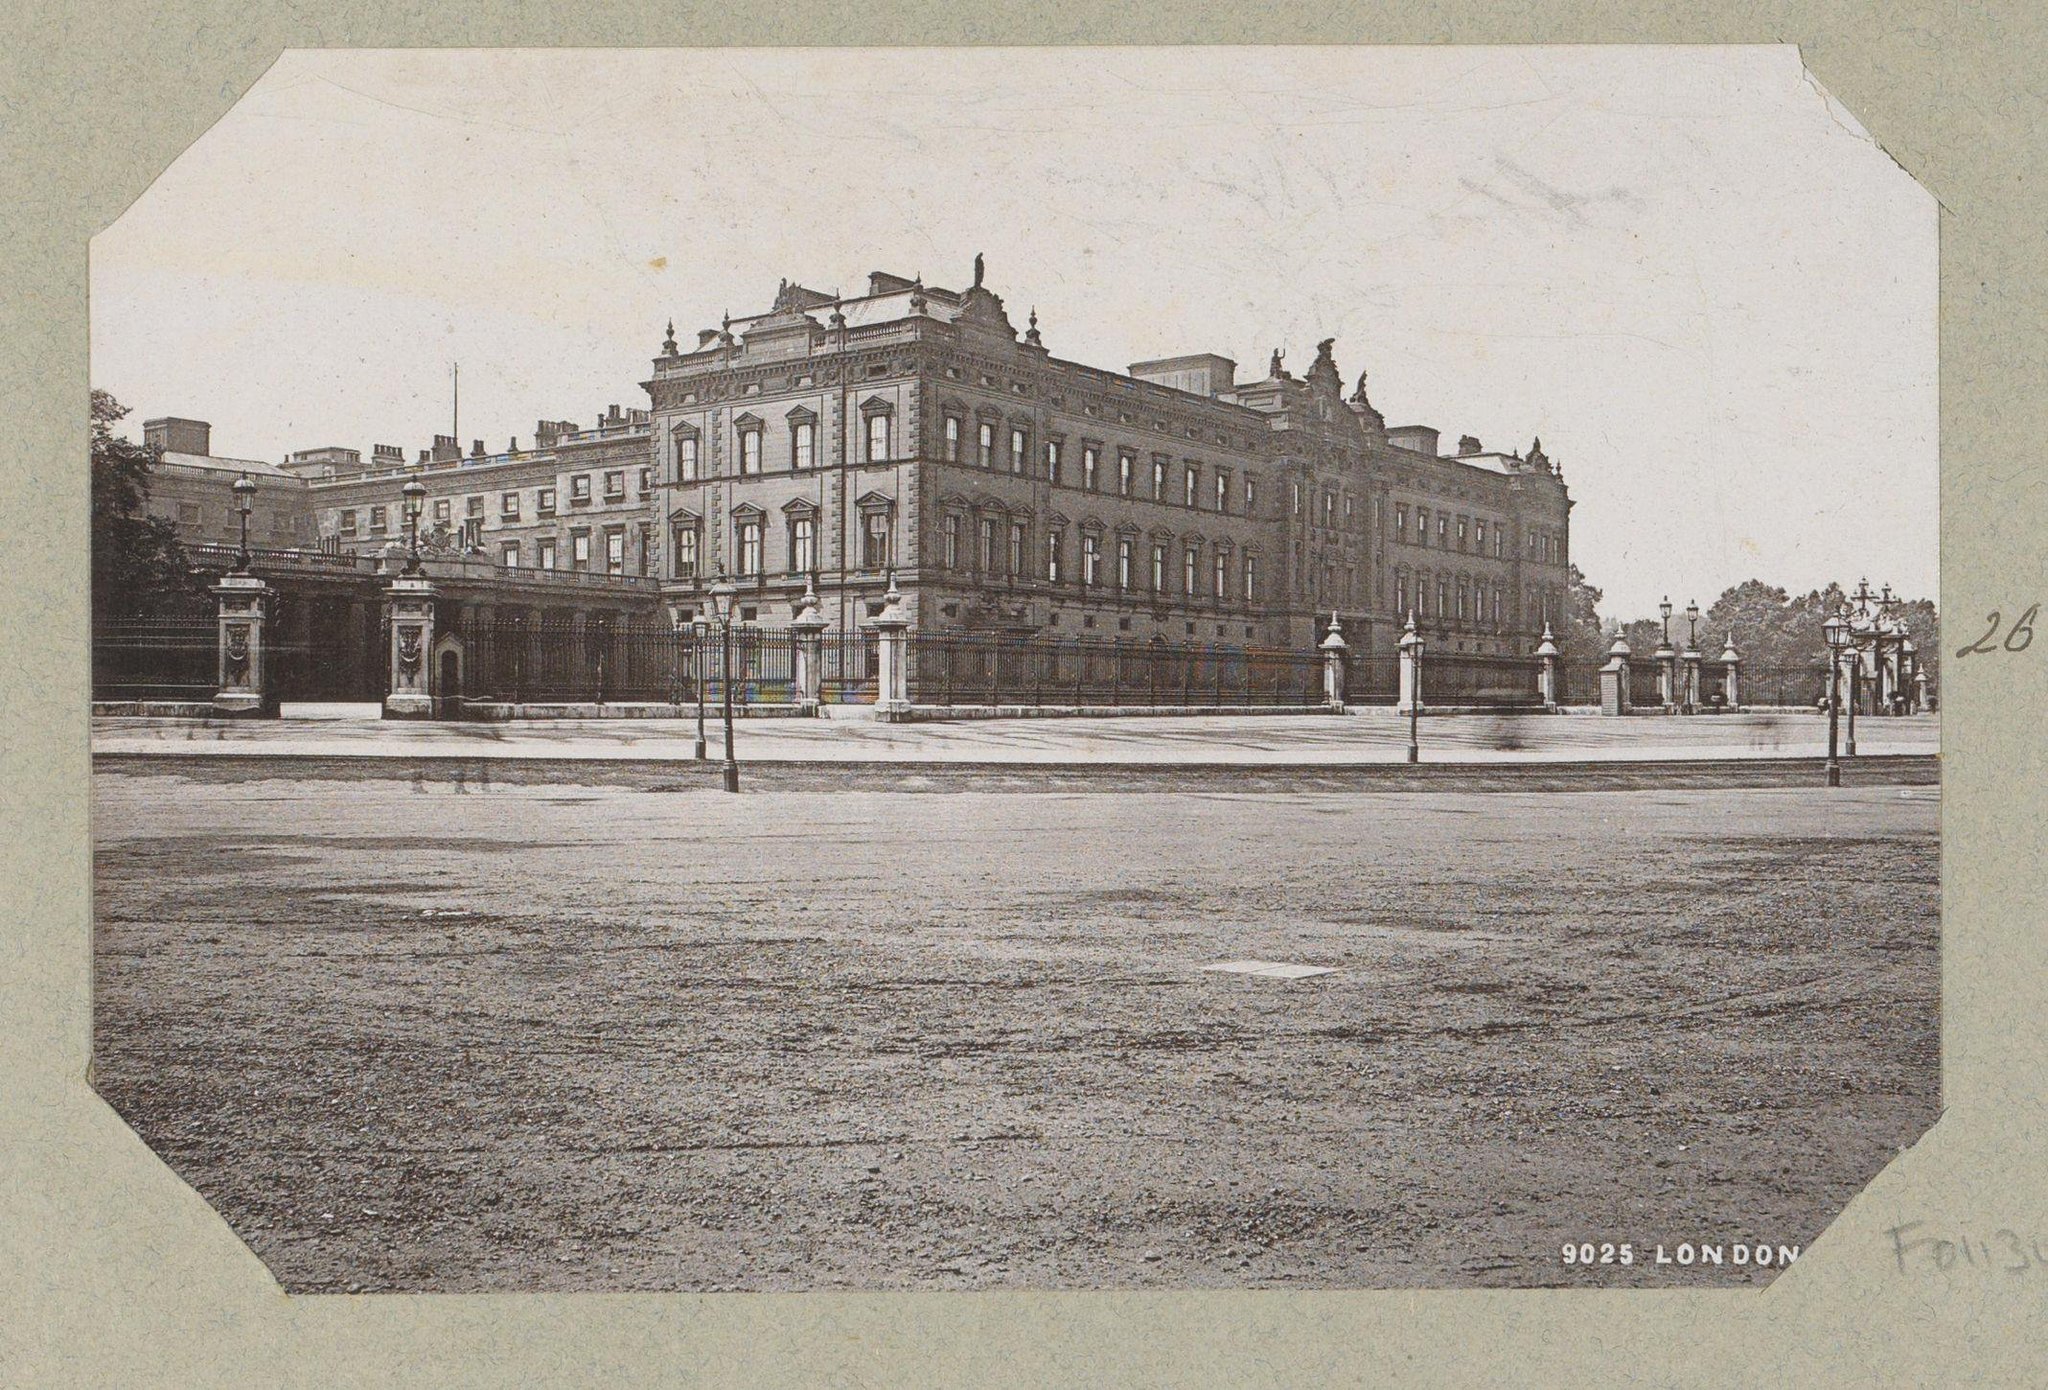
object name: photograph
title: London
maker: Anonymous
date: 1880-1910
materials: paper, ink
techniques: photograph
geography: dresden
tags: palace, london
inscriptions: stamp: ‘Römmler & Jonas Dresden 1895 / No.’, number: ‘9025’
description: Onderdeel van Reisalbum met bezienswaardigheden in Engeland, Zwitserland, Frankrijk en Duitsland.